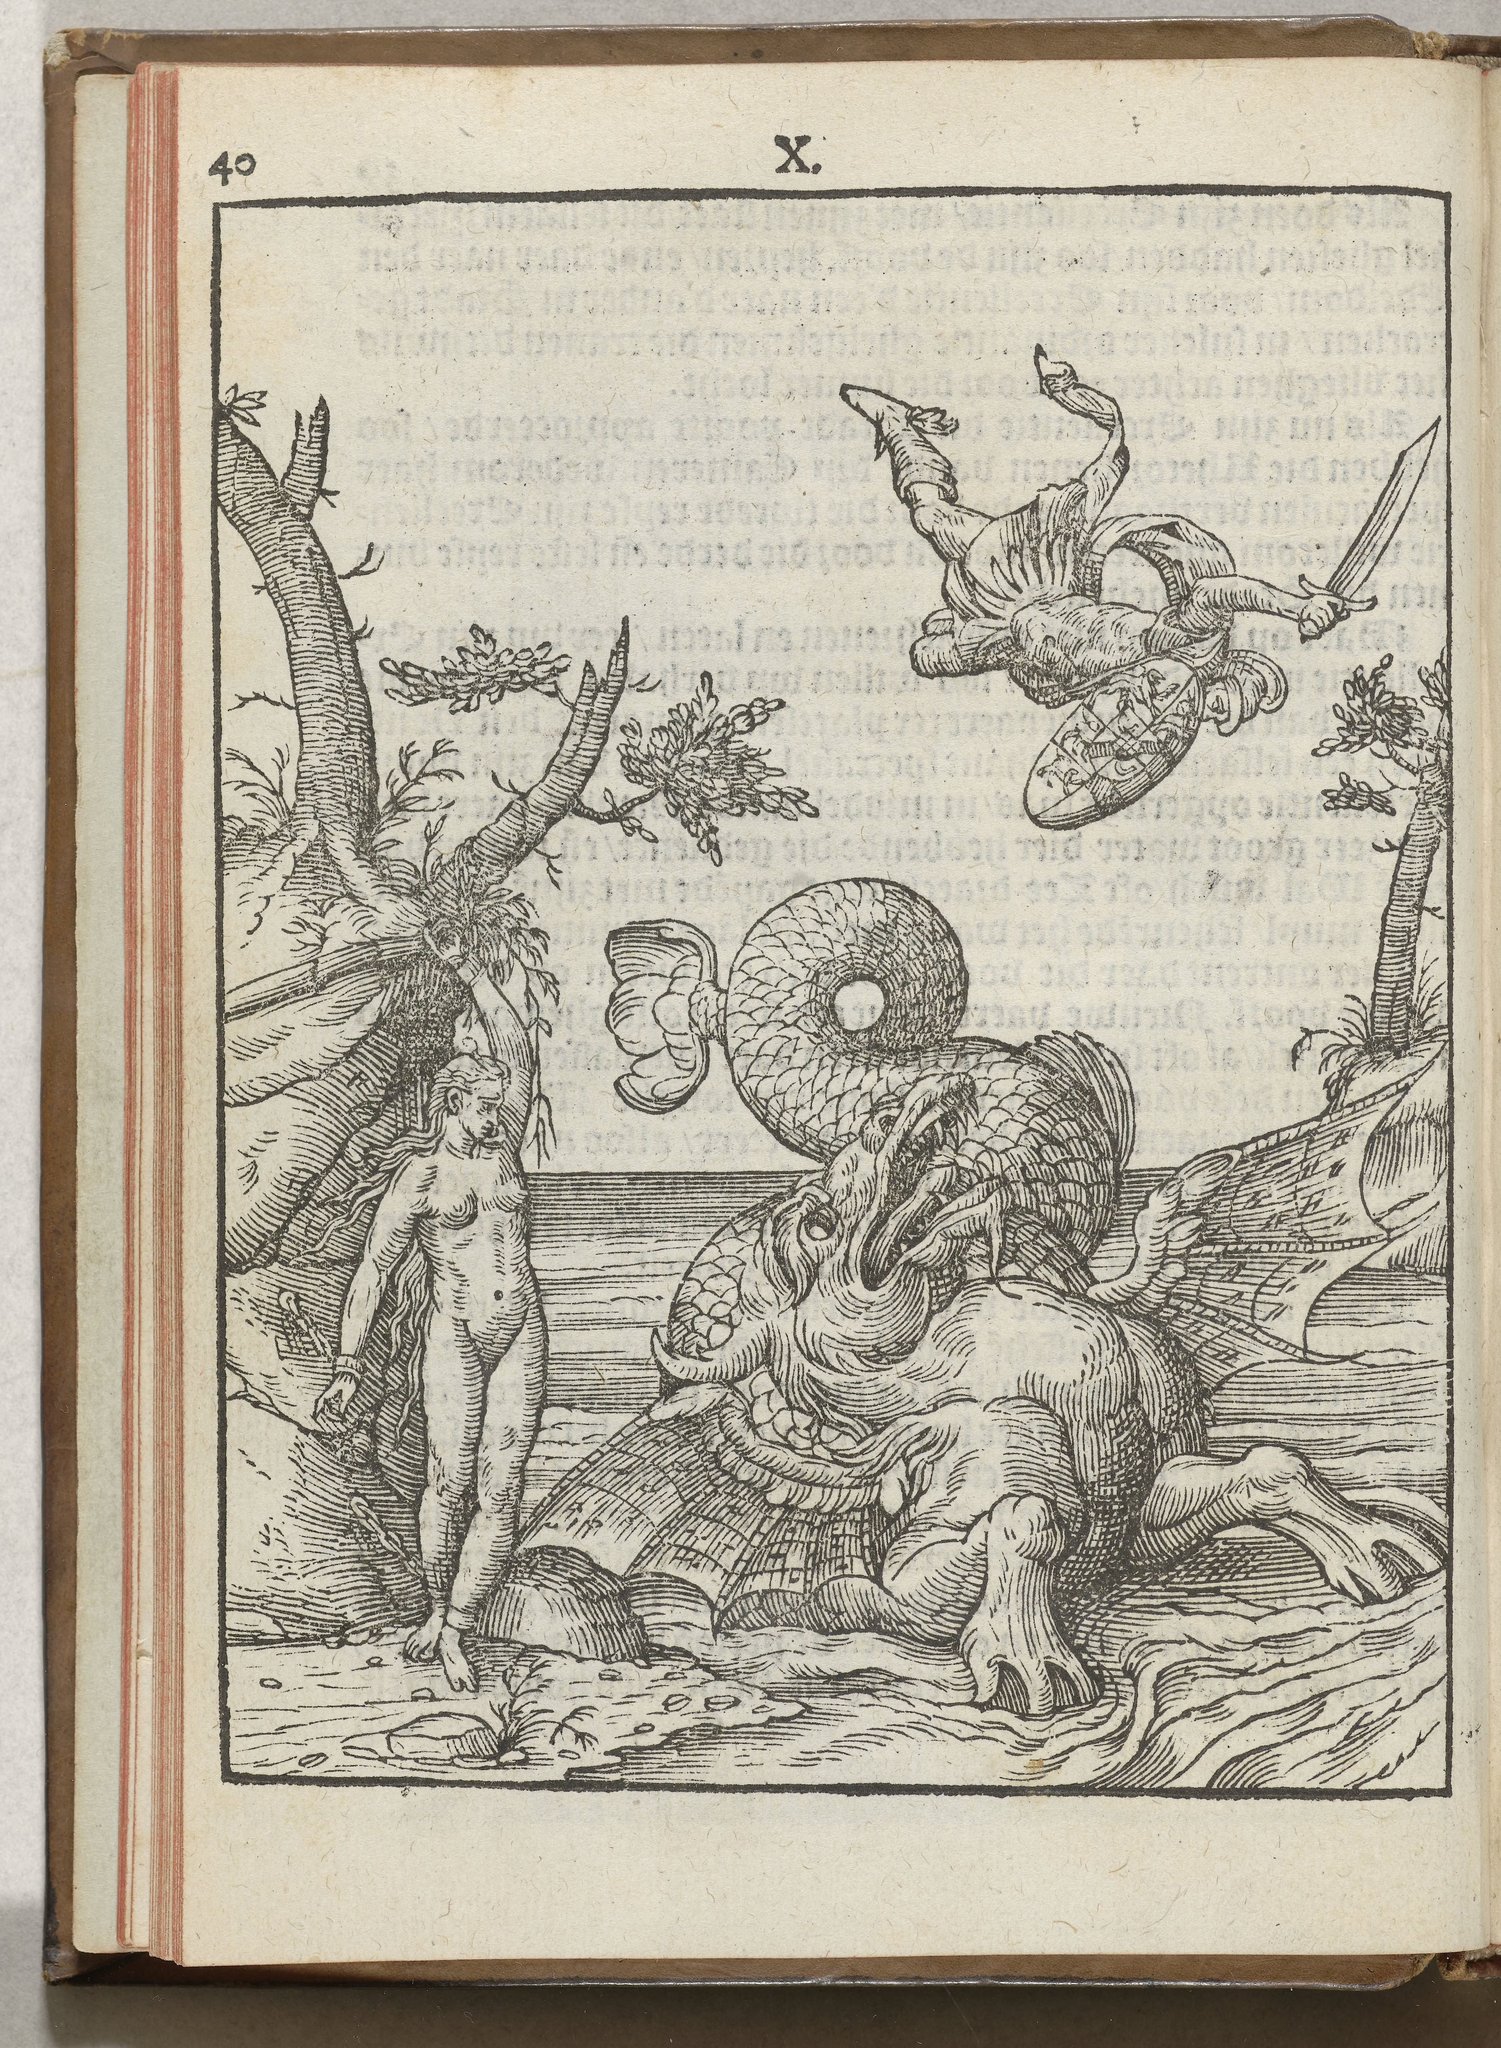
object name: print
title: Voorstelling van Perseus en Andromeda, 1577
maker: antoni van leest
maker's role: print maker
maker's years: 1545-1592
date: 1577-1578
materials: paper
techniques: woodcut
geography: netherlands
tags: delft, william i (prince of orange), perseus kills the sea monster (or turns it into stone by showing it the gorgon's head) to release andromeda; sometimes her parents cepheus and cassiopea watch the scene, triumphal entry and public reception, pageant, 'entrée solennelle', 'joyeuse entrée', brussels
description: Illustratie in: J. B. Houwaert, Declaratie van die triumphante incompst vande doorluchtighen ende hoogheboren Prine van Oraingnien, binnen die princelijcke stadt van Brussele, geschiet in t' iaer ... 1578, den 18 Septembris, Christoffel Plantijn, Antwerpen 1579. Boek in de bibliotheek met signatuur: 325 D 29.